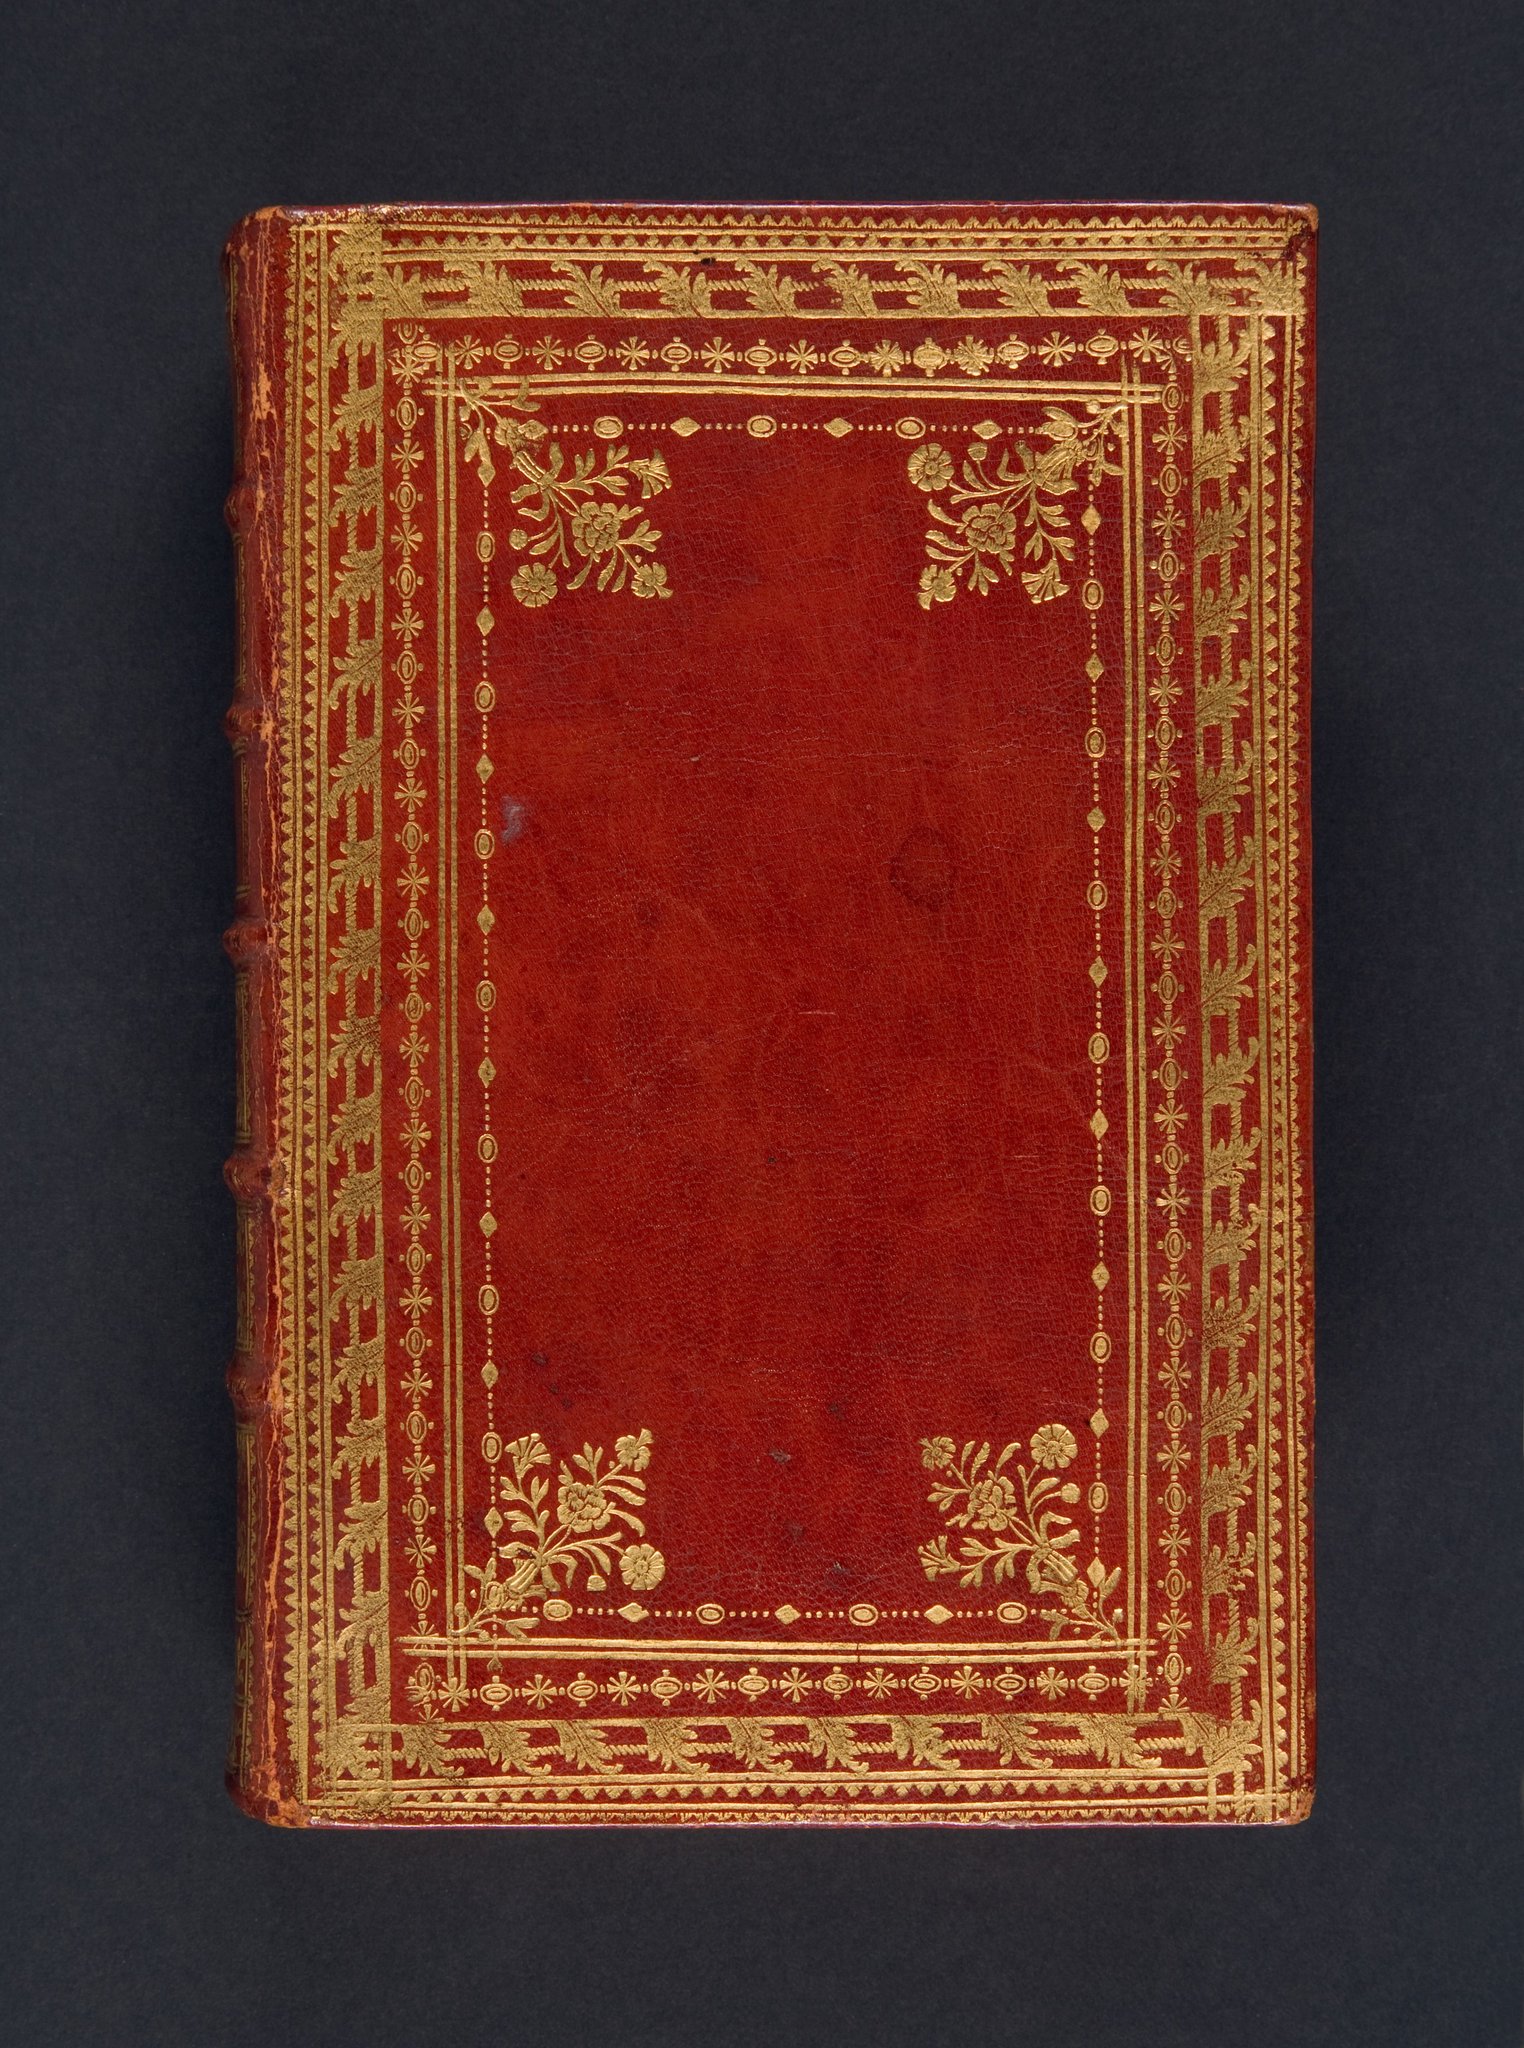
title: Almanach royal, année bissextile M.DCC.LXCII : présenté a sa Majeste pour la premiere fois en 1699 par Laurent d'Houry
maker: imprimerie de testu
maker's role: publisher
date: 1791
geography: france